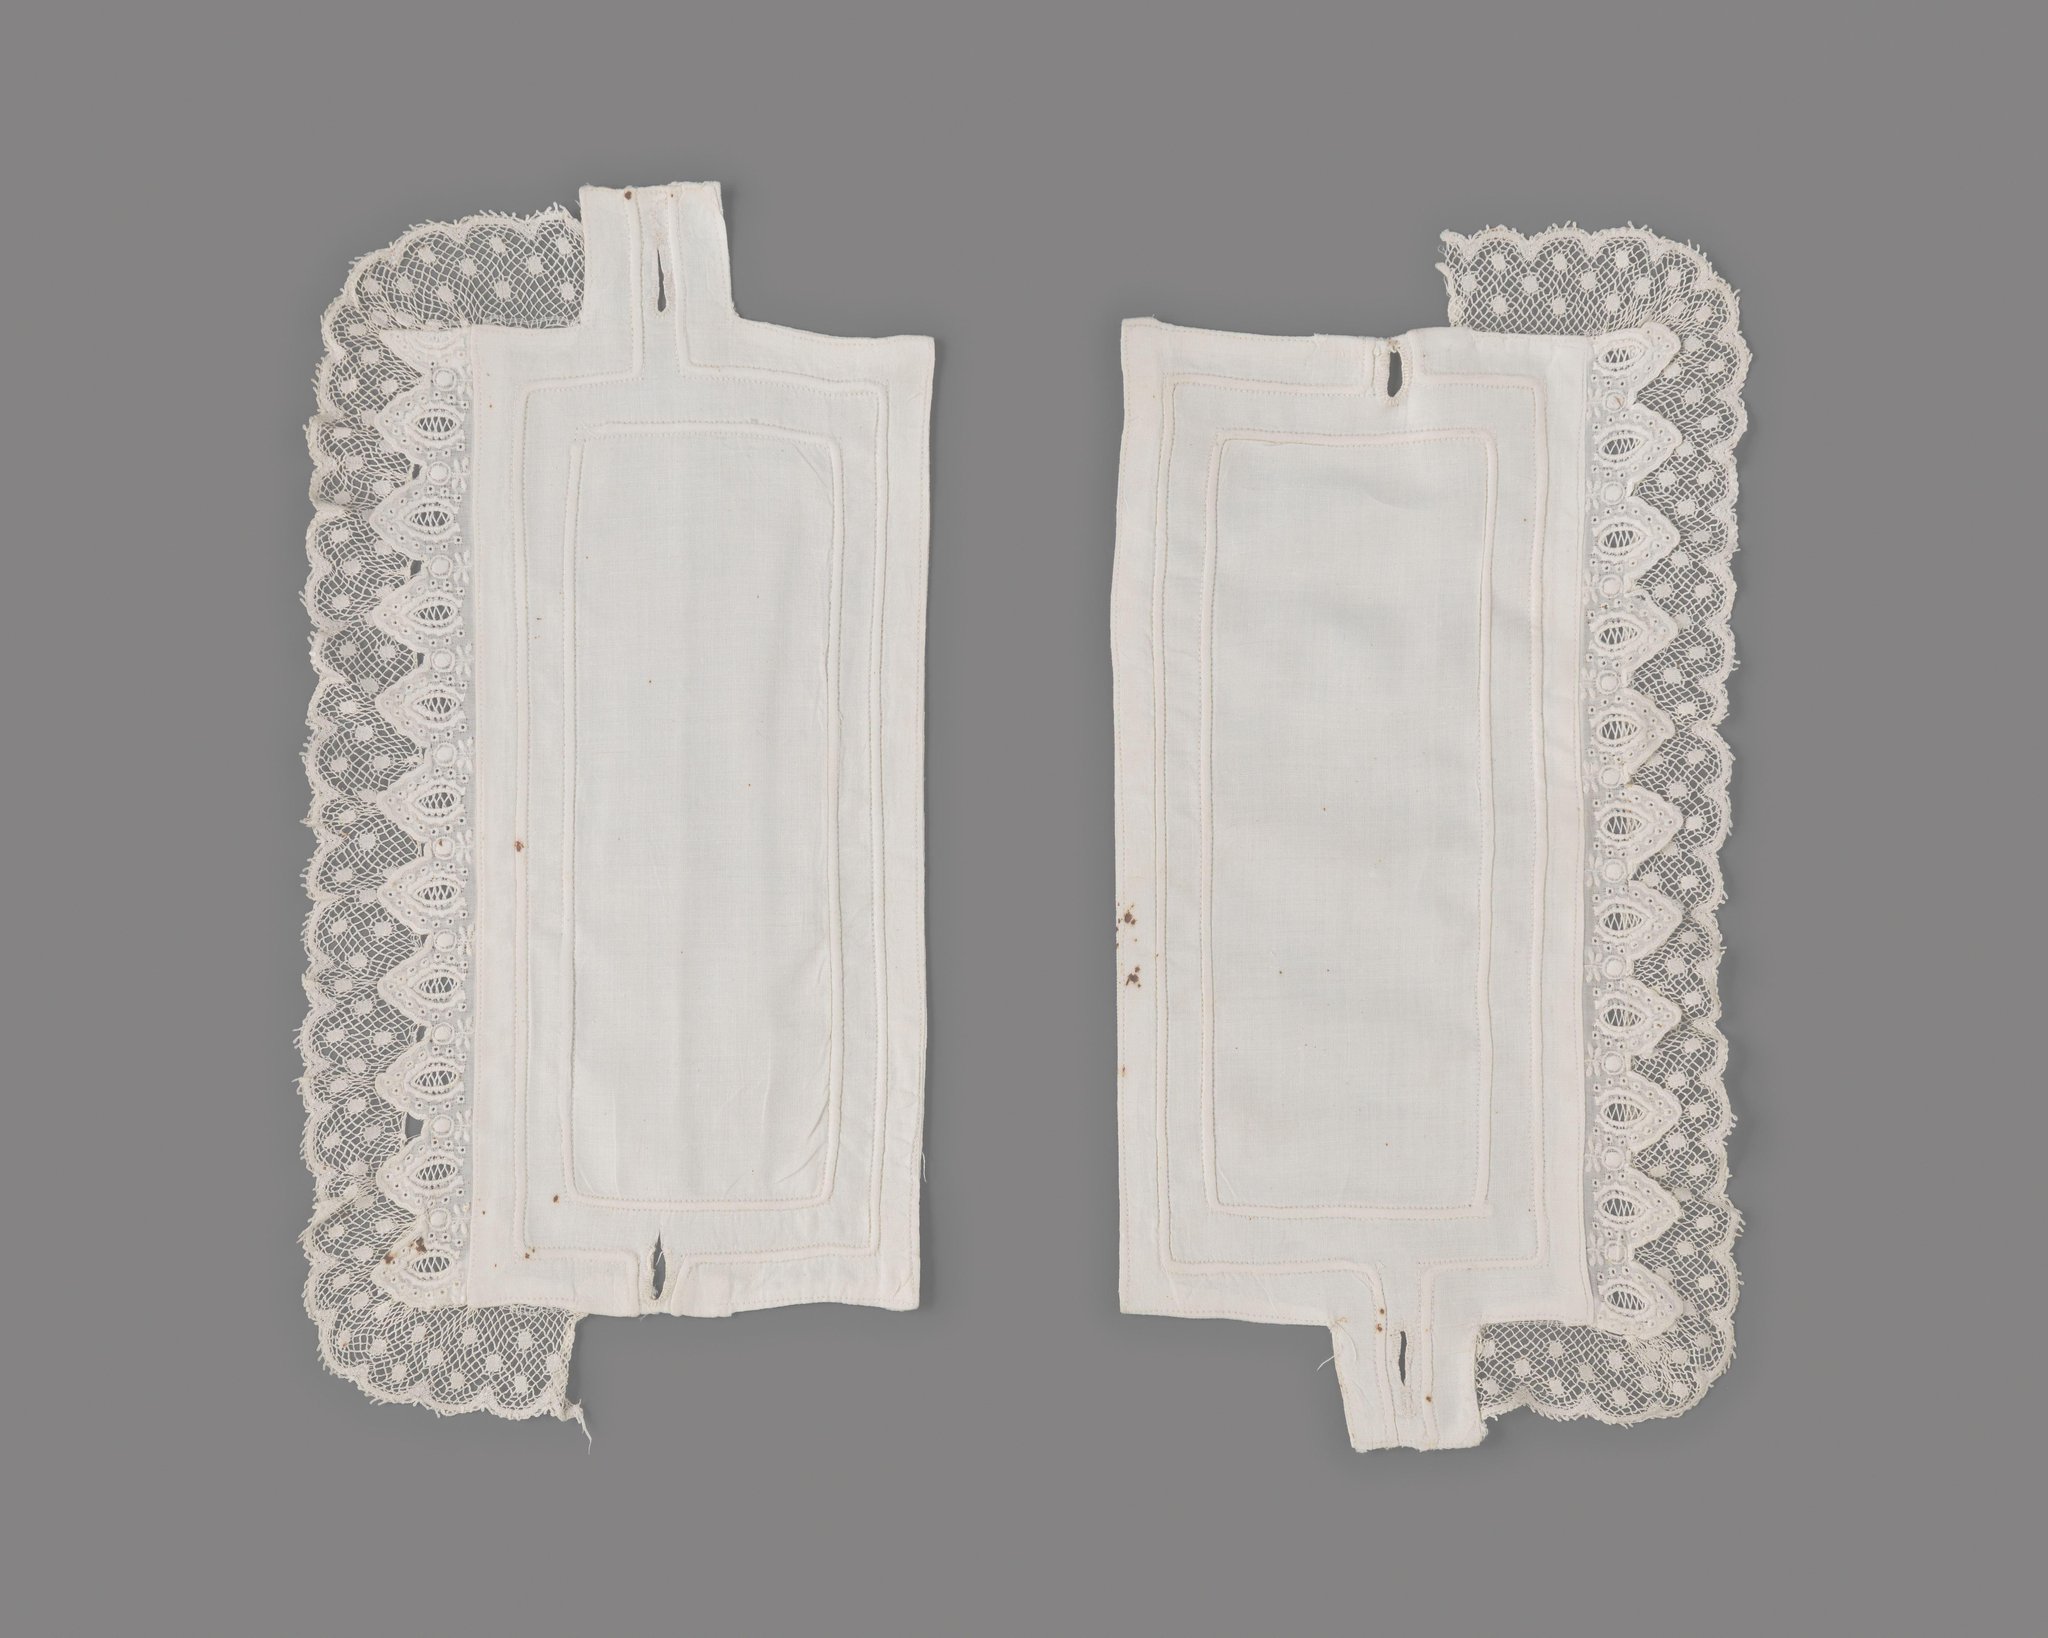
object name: clothing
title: Manchet met kantstrook afgezet met een gerimpeld aangezette strook Valenciennes-kant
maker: Anonymous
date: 1800-1920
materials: linen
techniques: cockled, embroidered, lace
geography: western europe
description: Manchet met kantstrook afgezet met een gerimpeld aangezette strook Valenciennes-kant met moesjes.